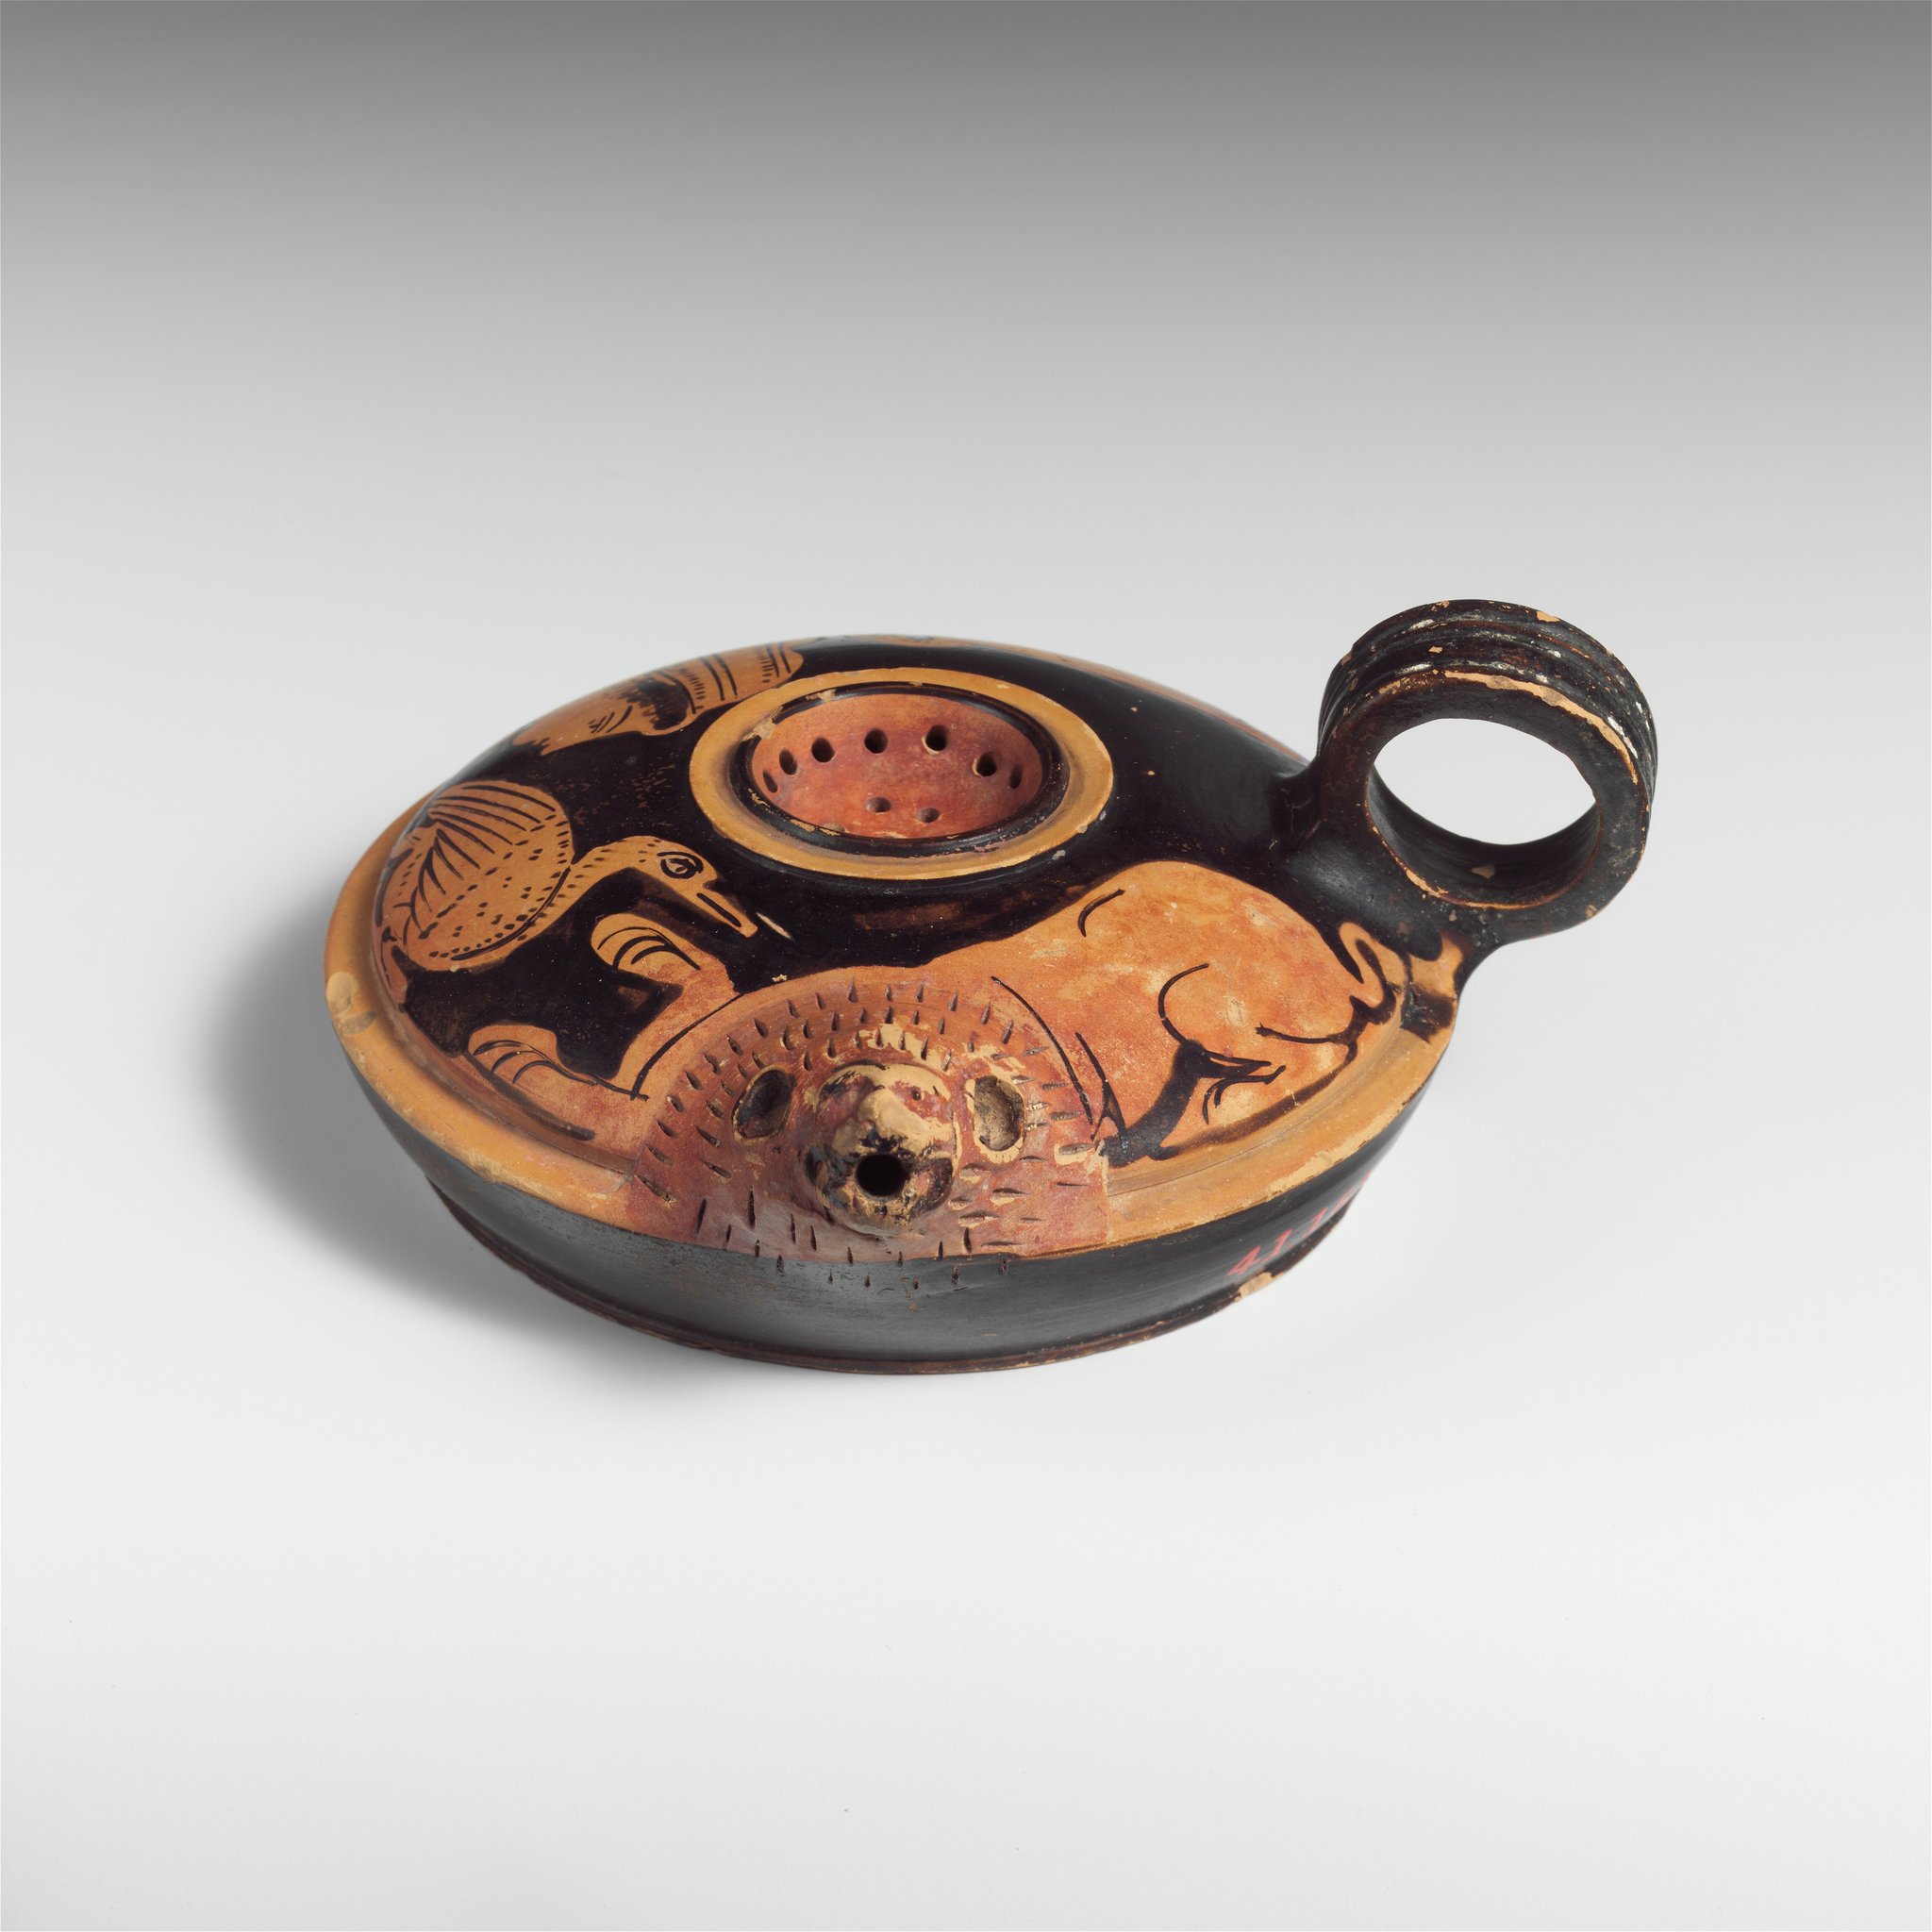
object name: strainer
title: Terracotta strainer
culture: greek, attic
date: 400-368 BCE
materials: terracotta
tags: birds,lions